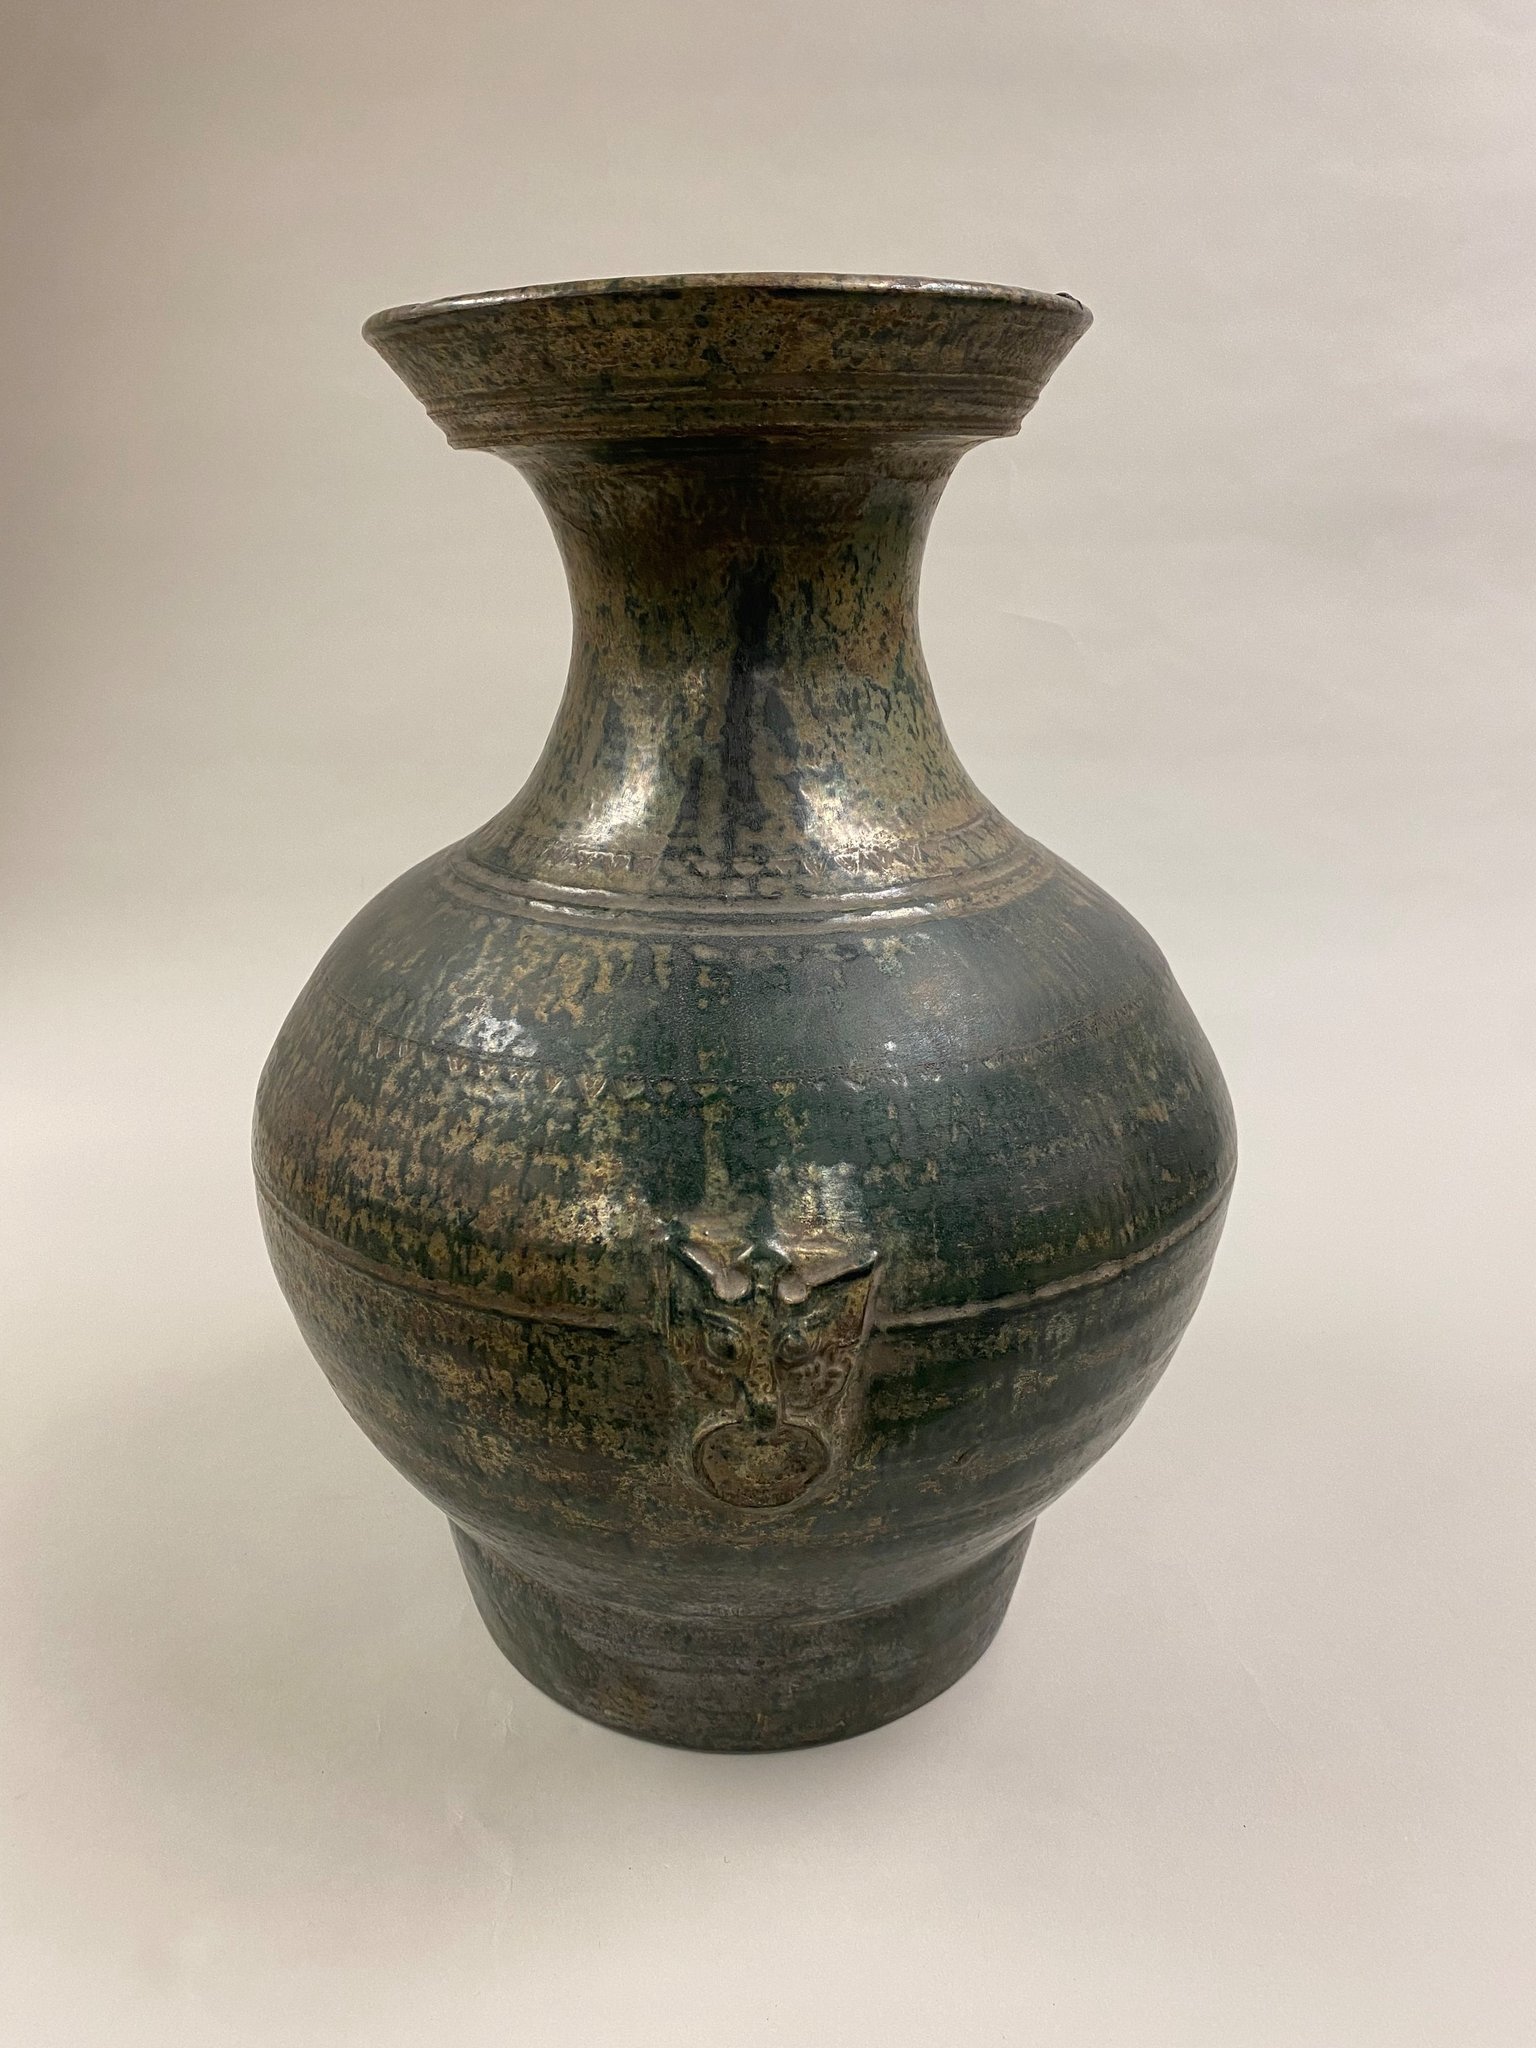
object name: wine container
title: Wine container (hu)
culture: chinese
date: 1-200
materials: earthenware, glaze, lead